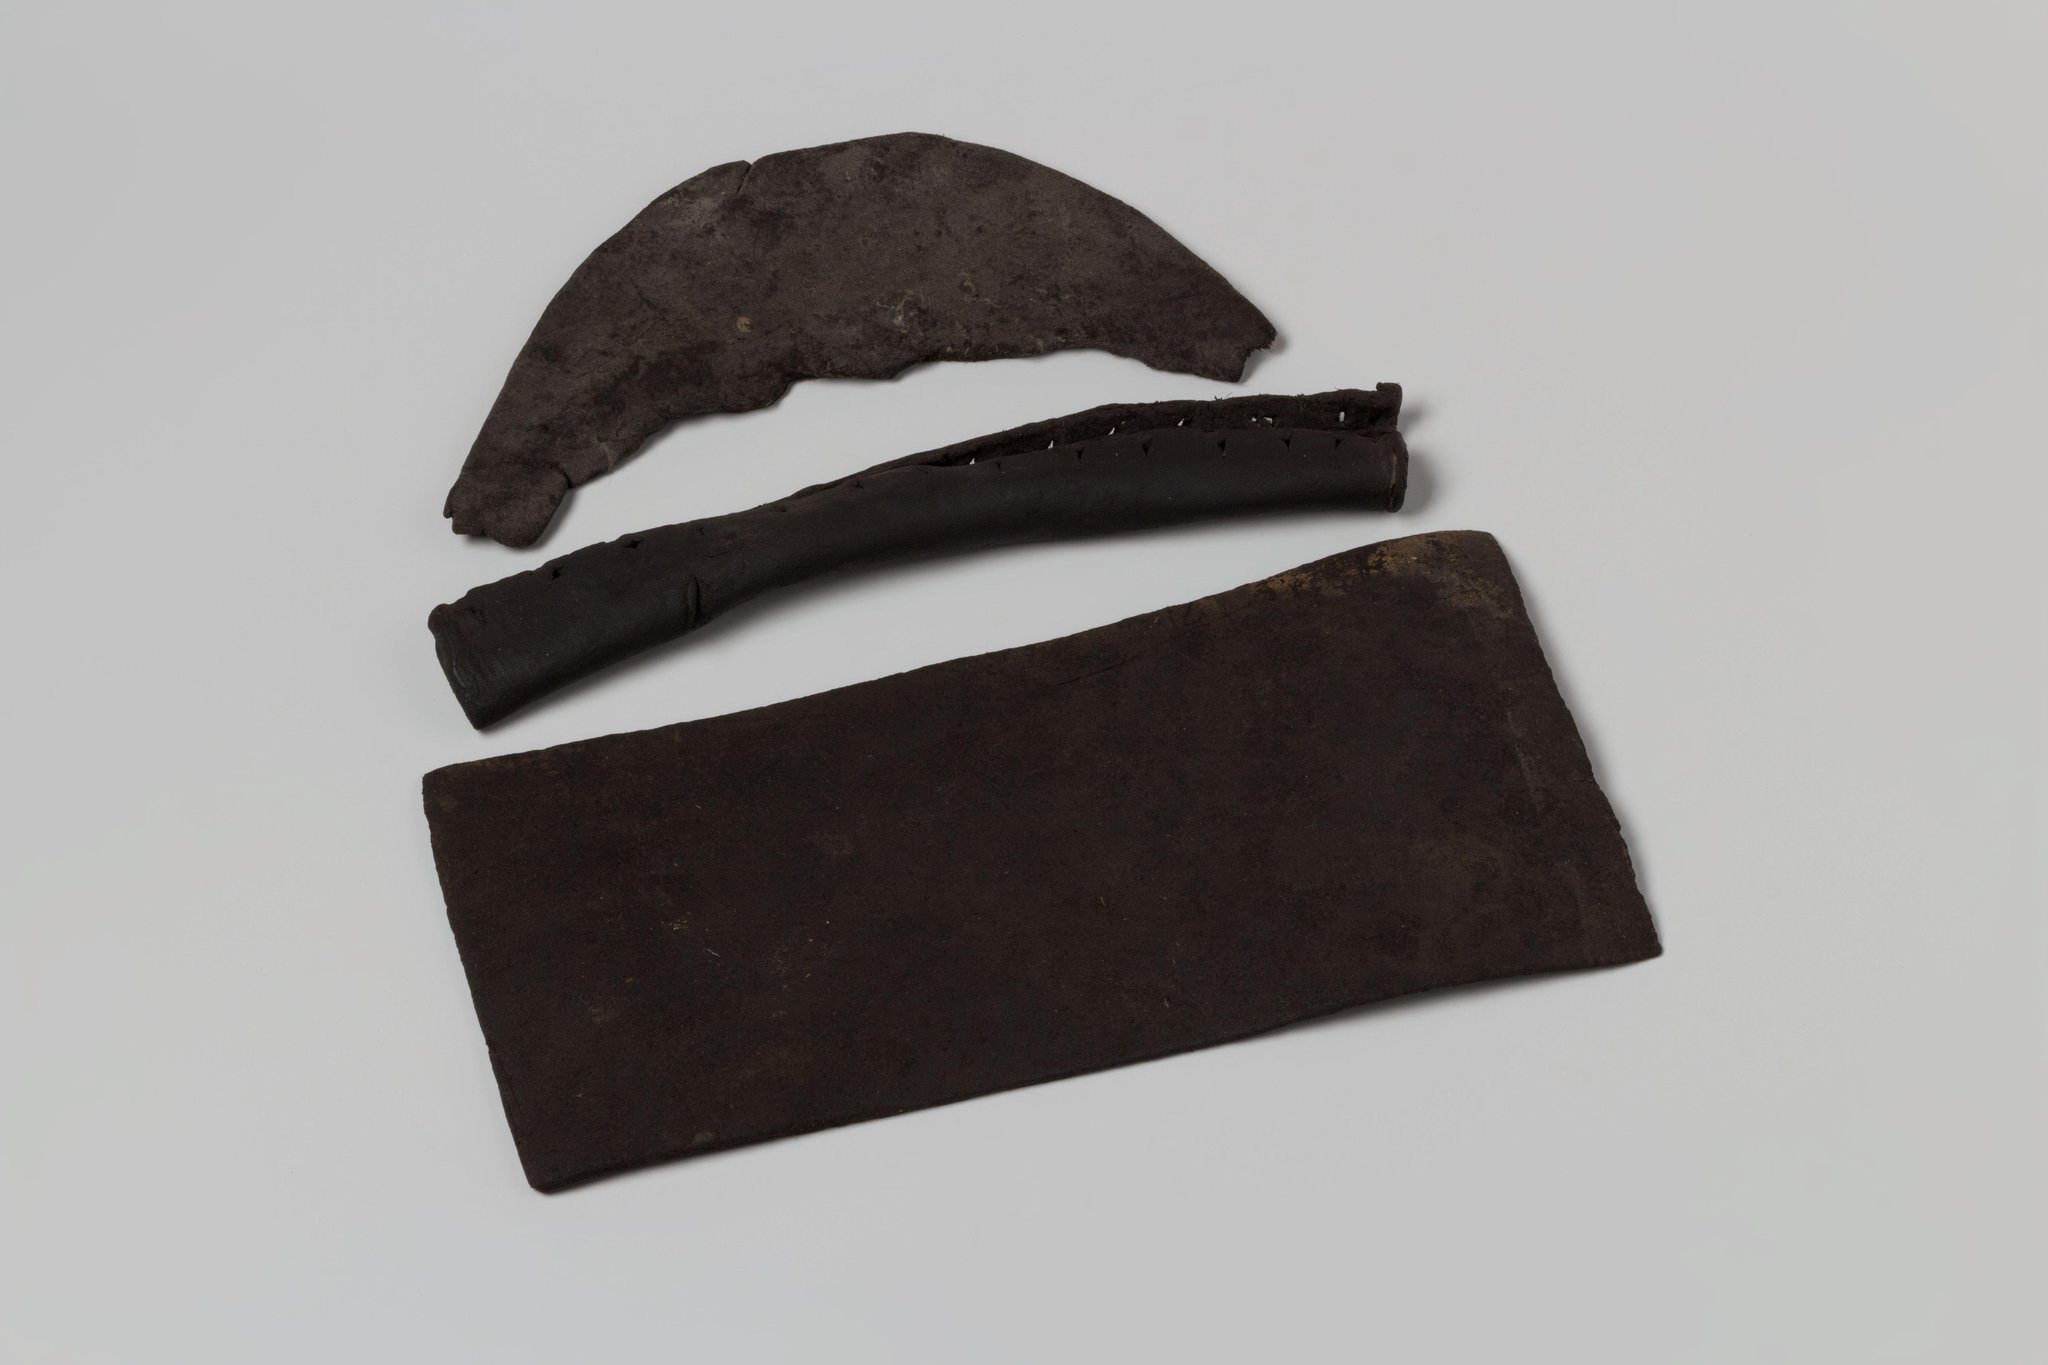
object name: fragment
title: Drie fragmenten van leer uit V.O.C.-schip de 'Witte Leeuw'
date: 1613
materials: leather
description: Drie leren fragmenten. Eén sikkelvormig fragment, één rechthoekig fragmenten en een fragment dat gerold/gevouwen is met gaatjes langs de randen om het dicht te binden.